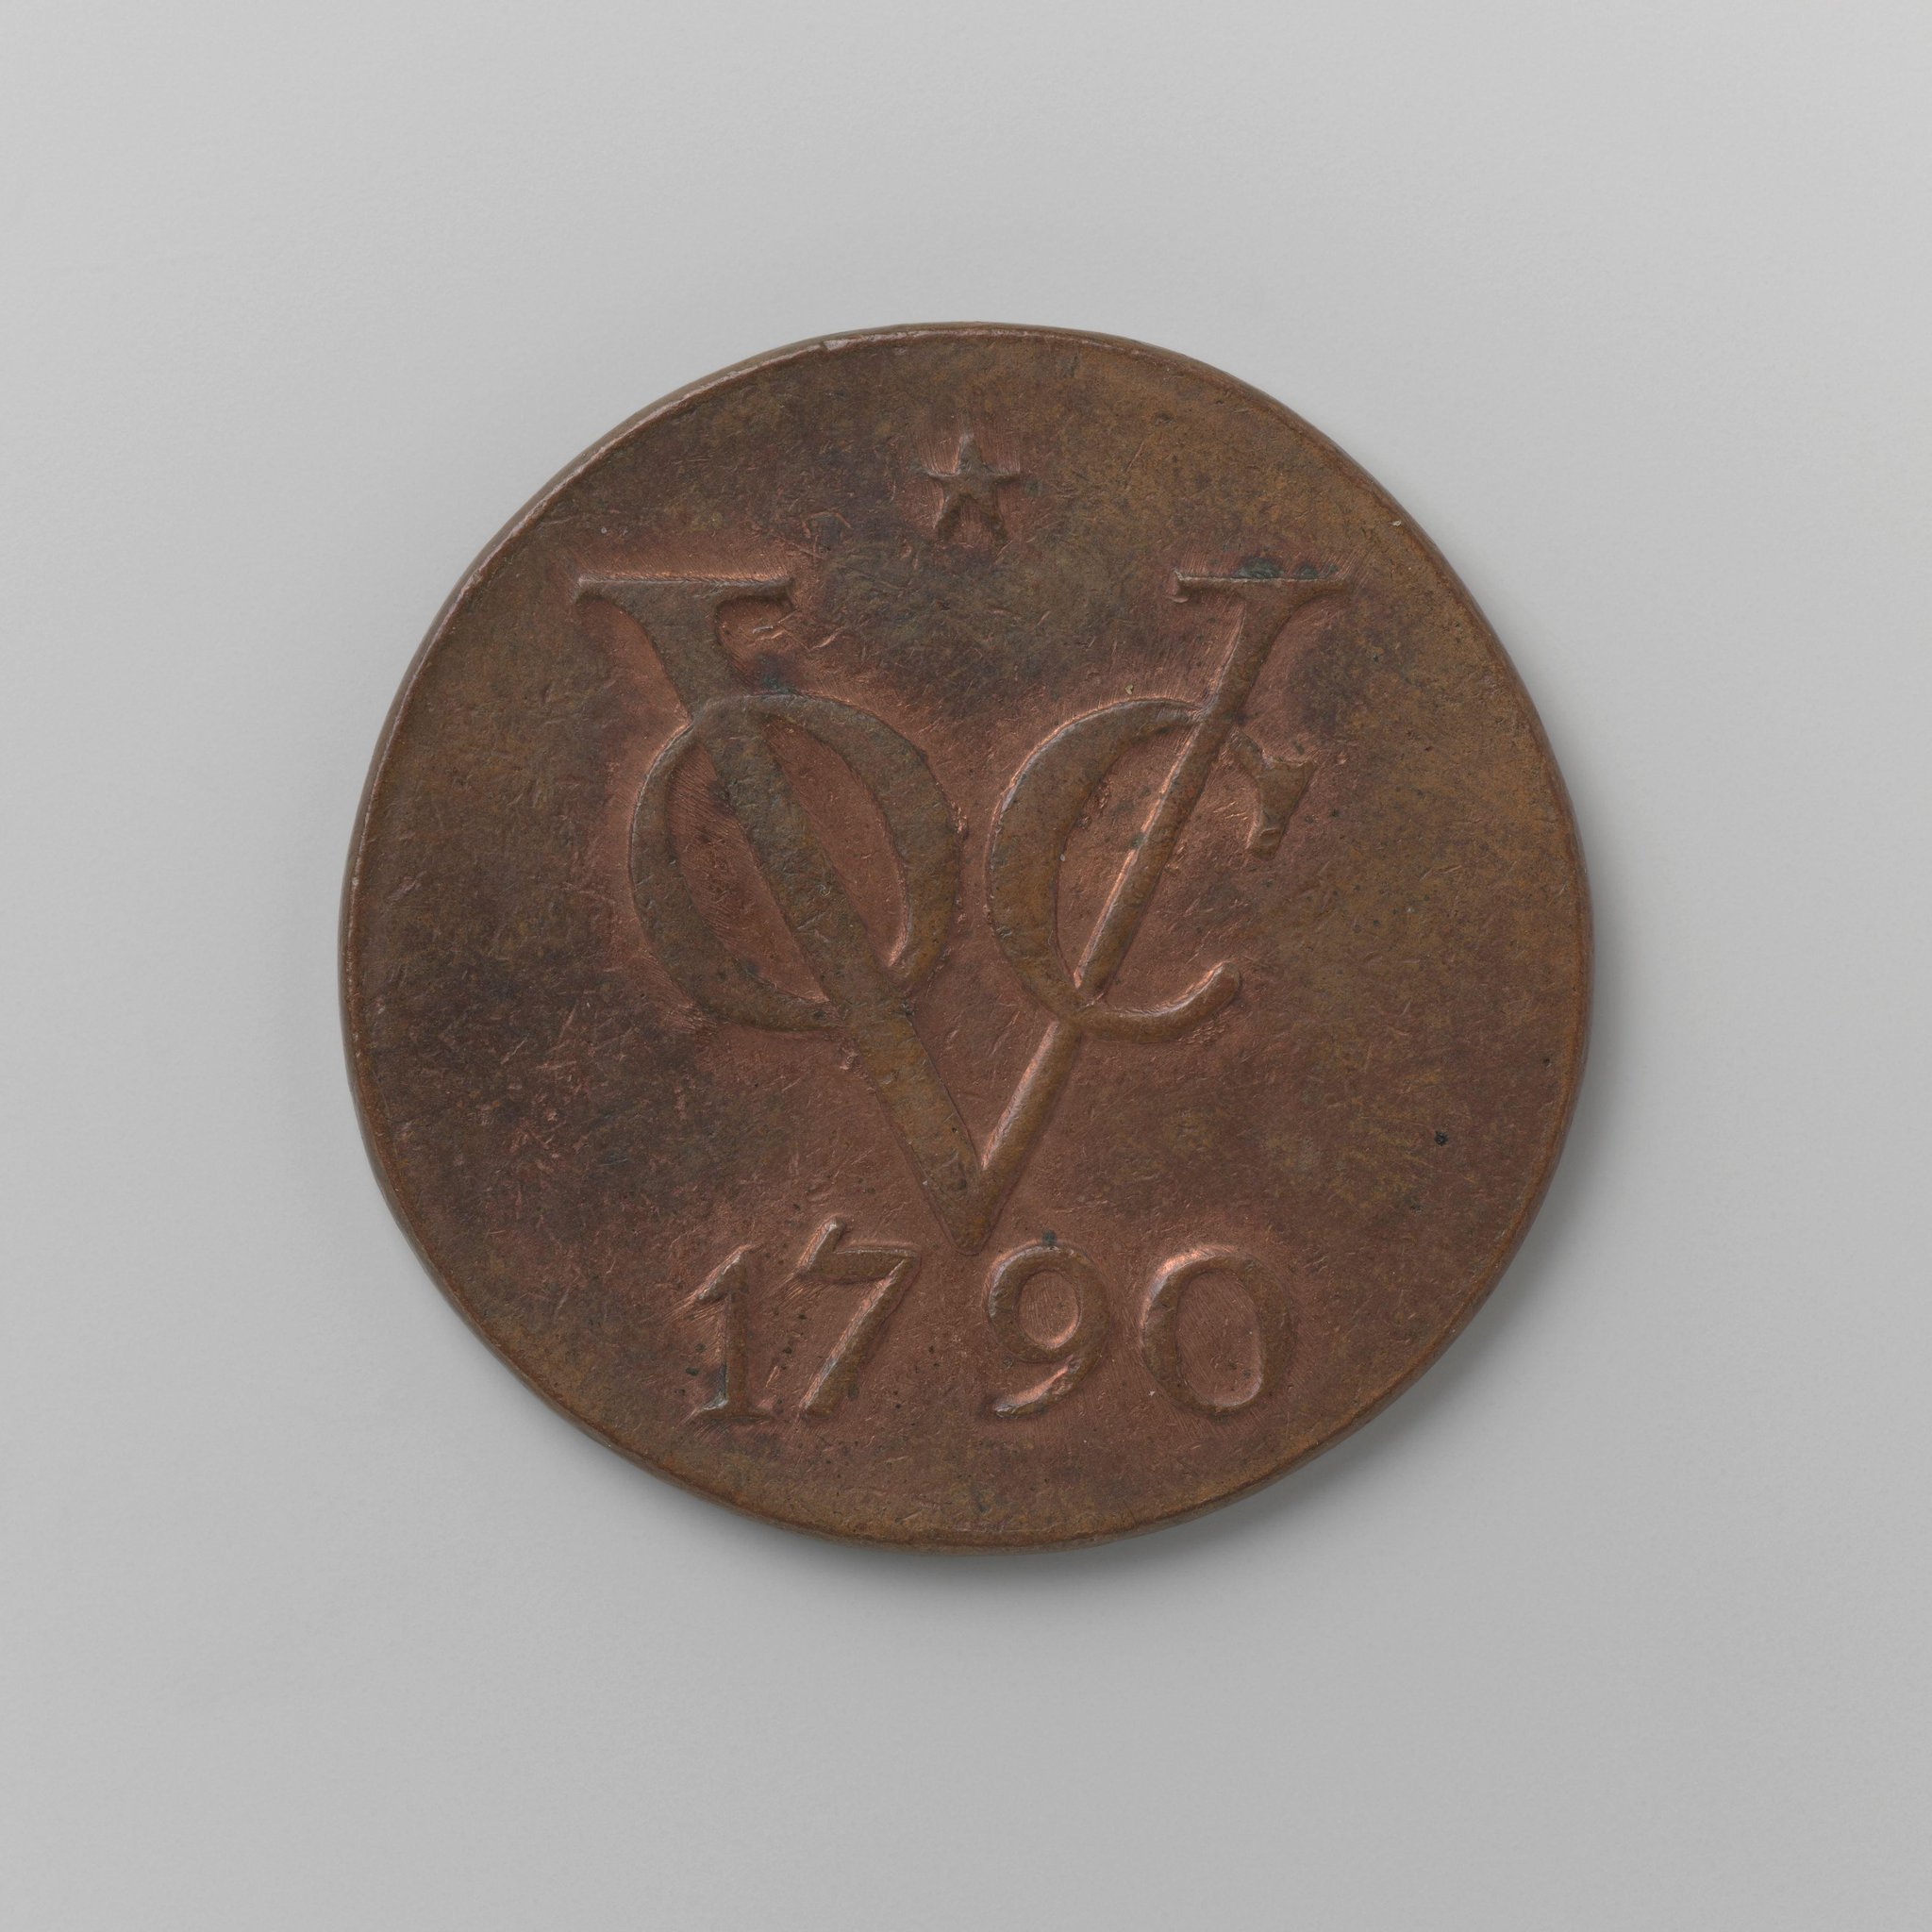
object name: coin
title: Dubbele duit op naam van de VOC en de stad Utrecht met jaartal 1790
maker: william ii of the netherlands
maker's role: koning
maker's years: 1792-1849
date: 1840-1843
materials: copper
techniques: striking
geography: surabaya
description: Koperen munt. Voorzijde: op balk, waaronder guirlande, staand, door twee leeuwen gehouden gekroond wapenschild van de stad Utrecht. Keerzijde: monogram van de VOC, waarboven muntteken ster en waaronder fictief jaartal 1790. Gladde rand.